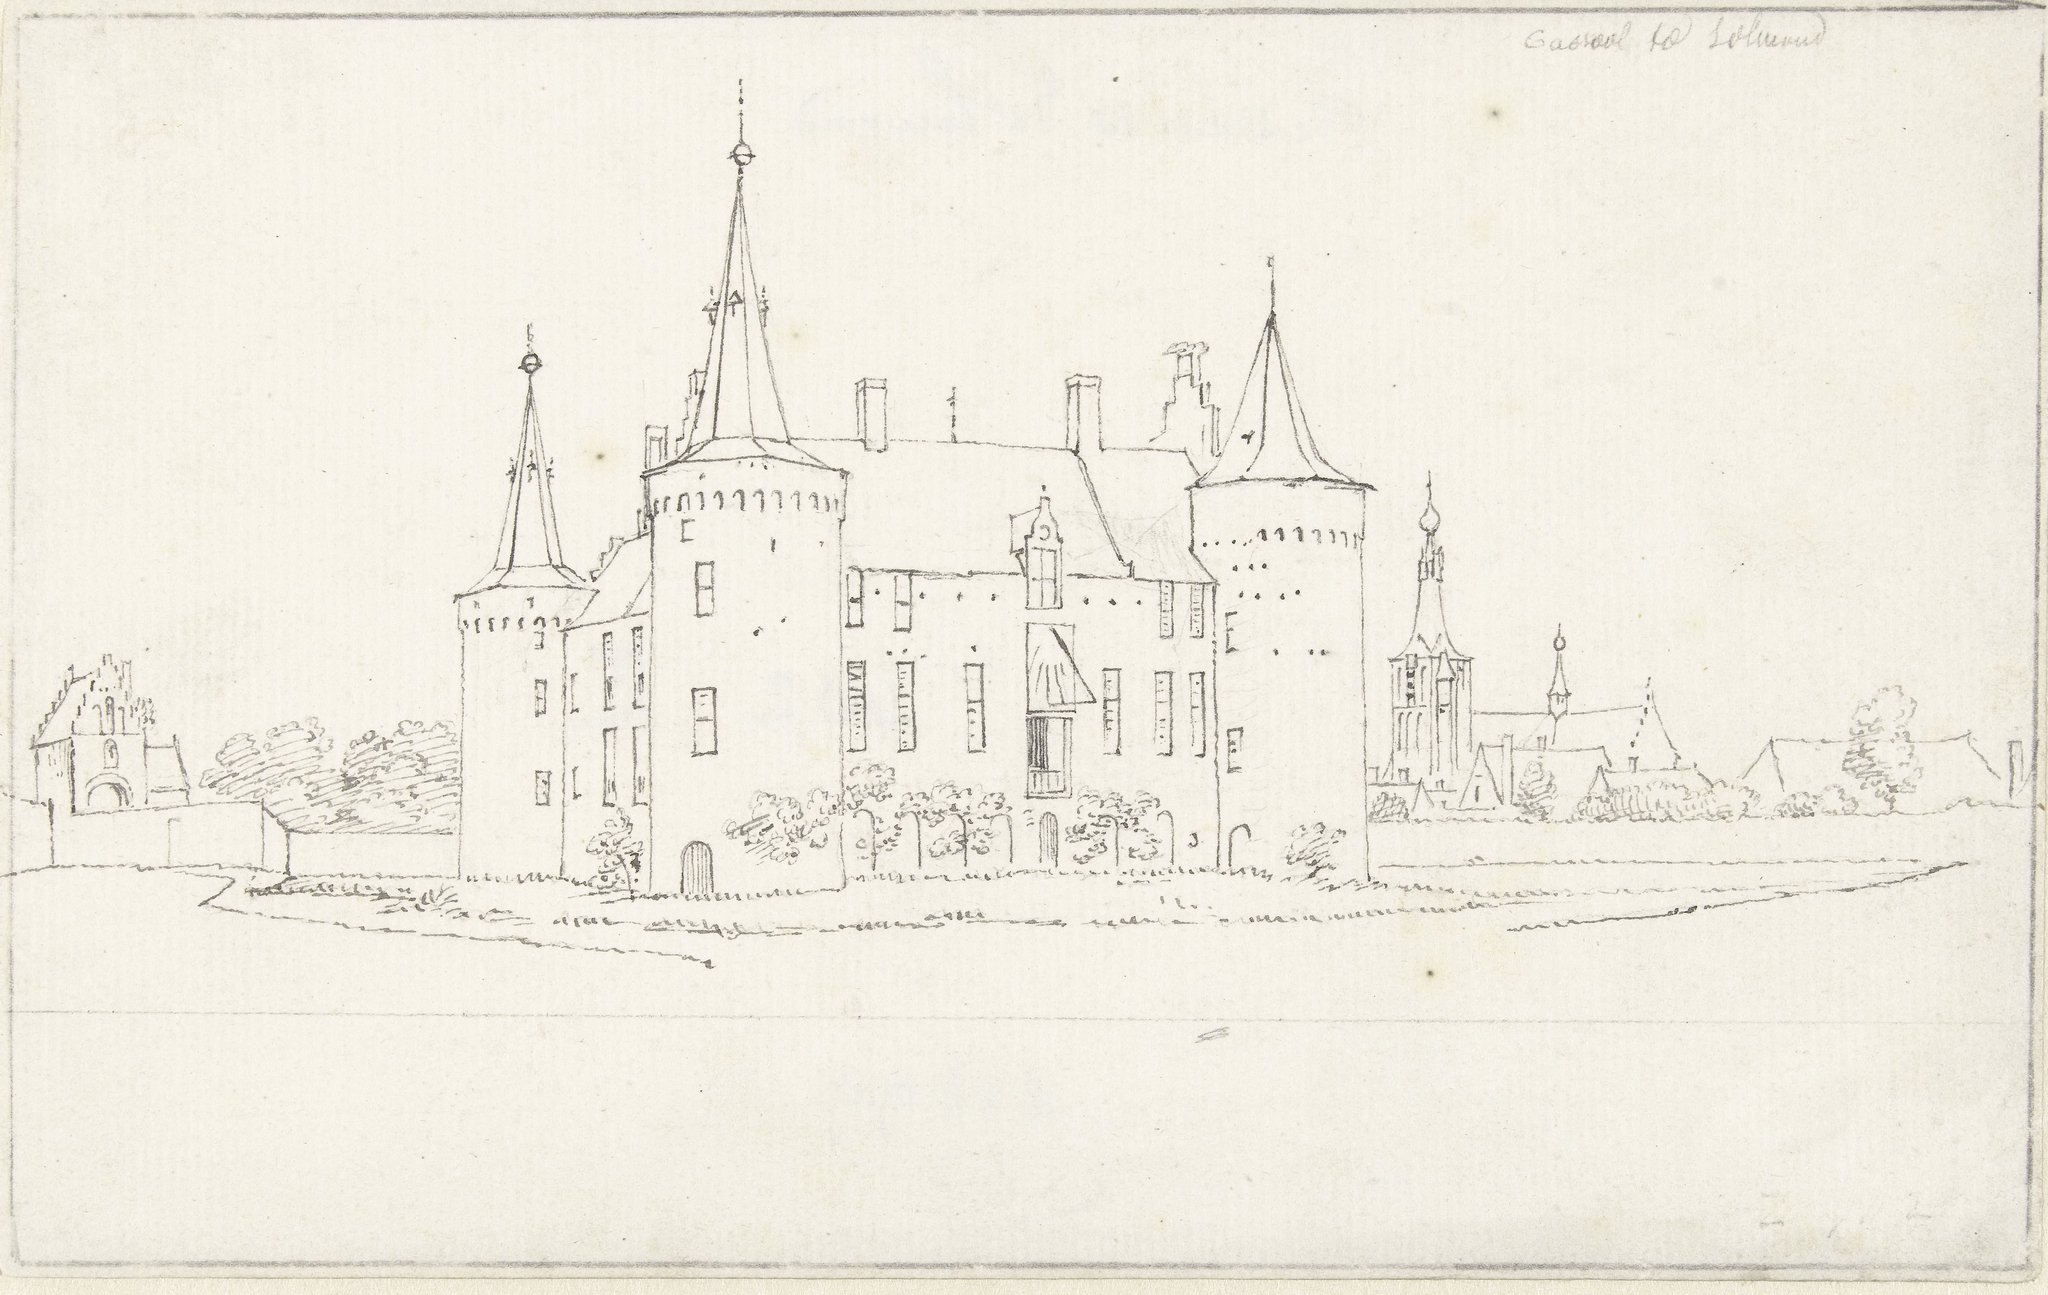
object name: drawing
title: Het kasteel te Helmond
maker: cornelis pronk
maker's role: draughtsman, painter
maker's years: 1691-1759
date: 1720-1740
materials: ink, paper, pencil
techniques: pen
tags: city-view, and landscape with man-made constructions, castle, church (exterior)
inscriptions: inscription: ‘casteel te Helmond’, inscription: ‘casteel te Helmond’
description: Links het poortgebouw en rechts de Sint-Lambertuskerk.